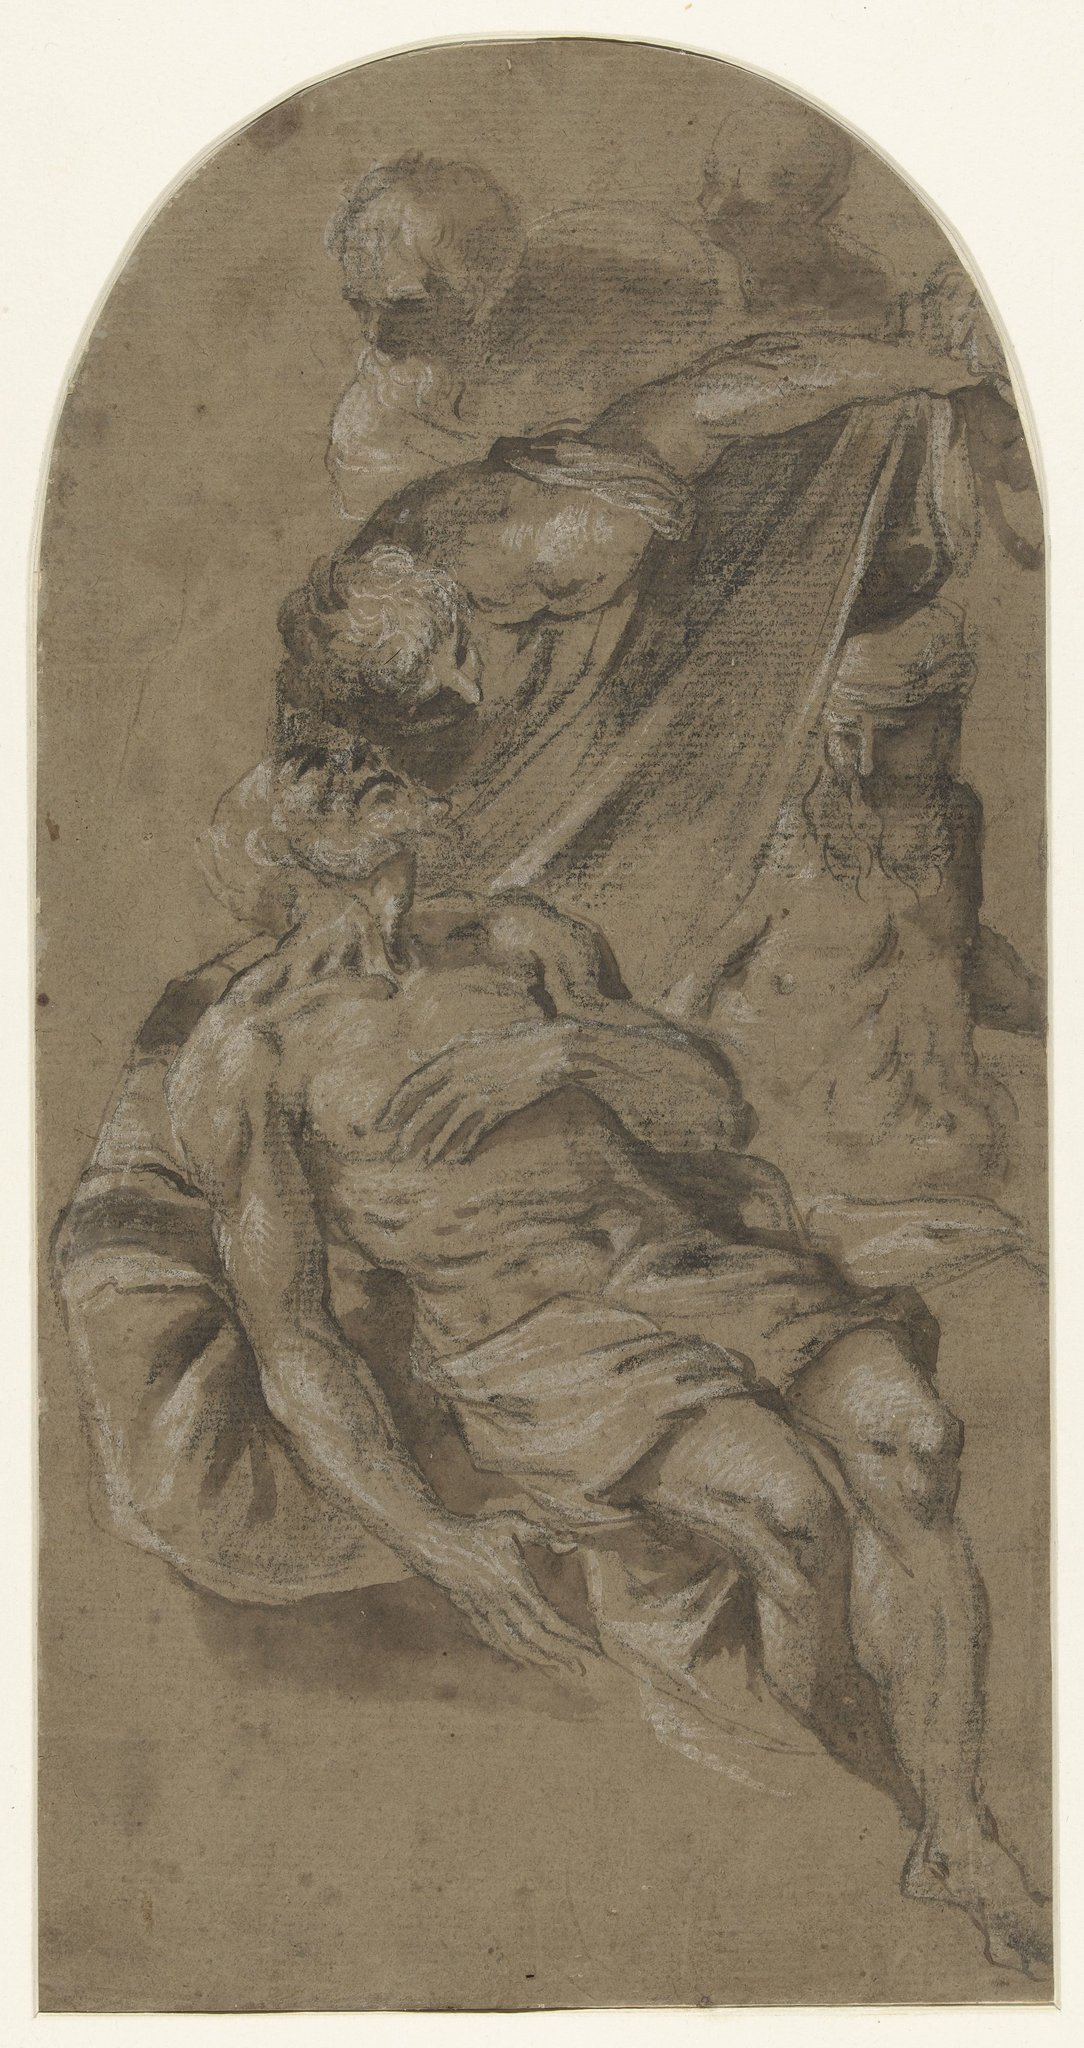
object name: drawing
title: De zieken bij de vijver van Bethesda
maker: domenico maria canuti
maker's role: draughtsman, print maker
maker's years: 1620-1684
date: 1630-1684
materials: chalk, paper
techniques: brush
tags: sick people lying near the pool of bethesda ~ christ healing paralytics (john 5:1-9)